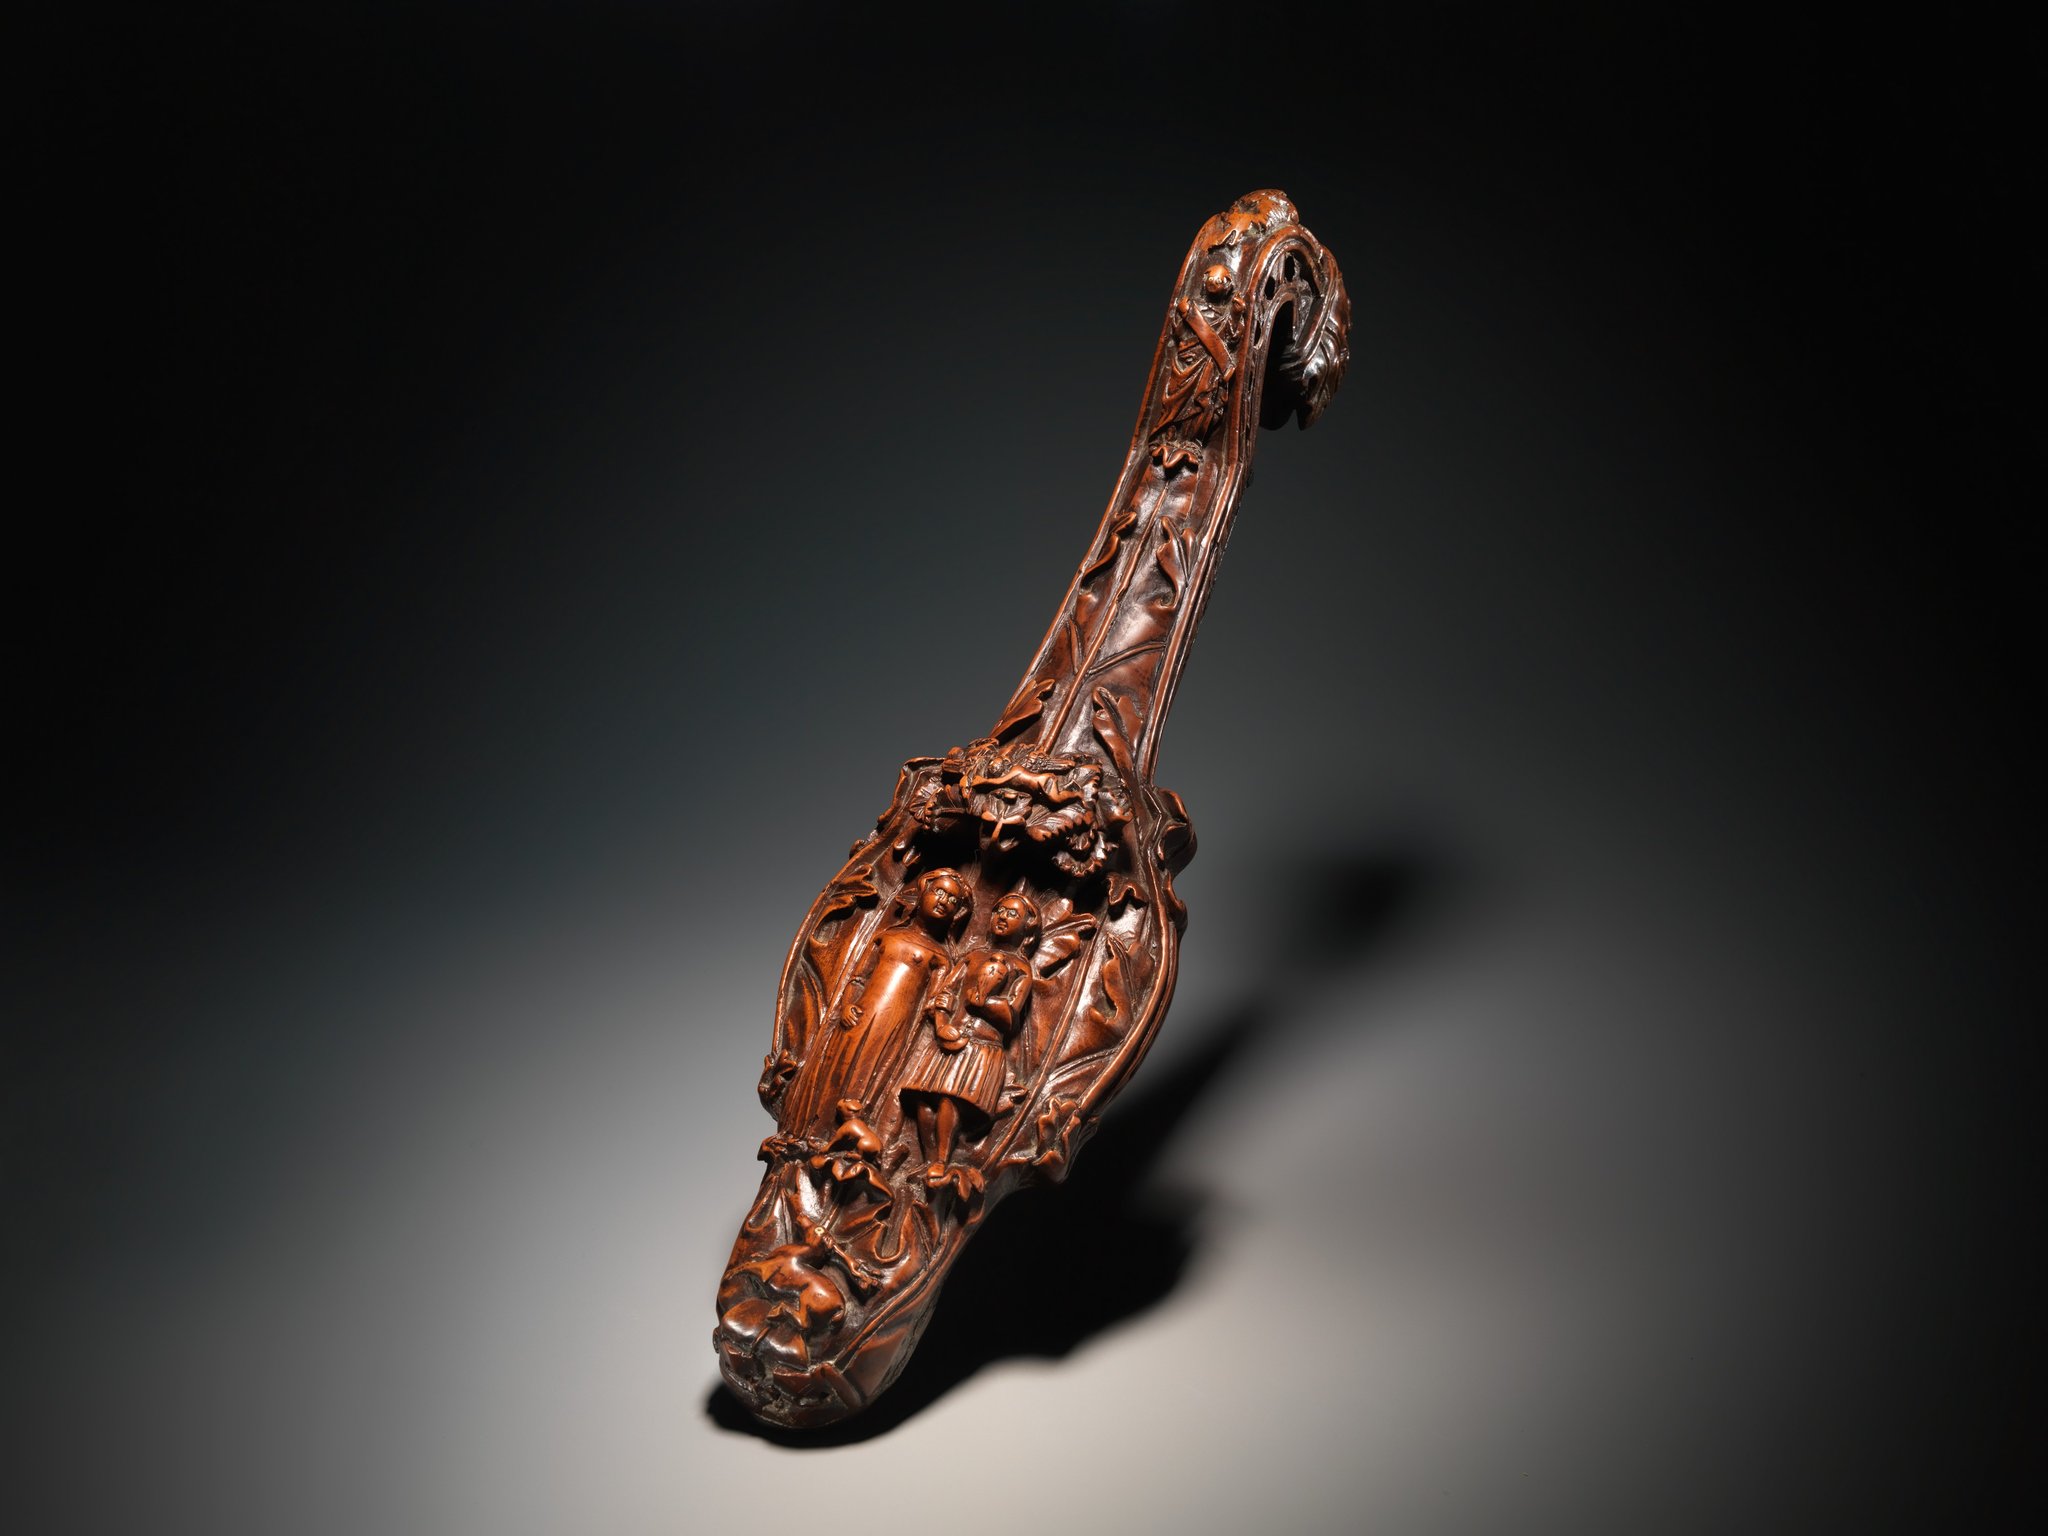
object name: mandora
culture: italian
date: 1420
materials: wood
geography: italy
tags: falcons,men,women,cupid,deer,dogs